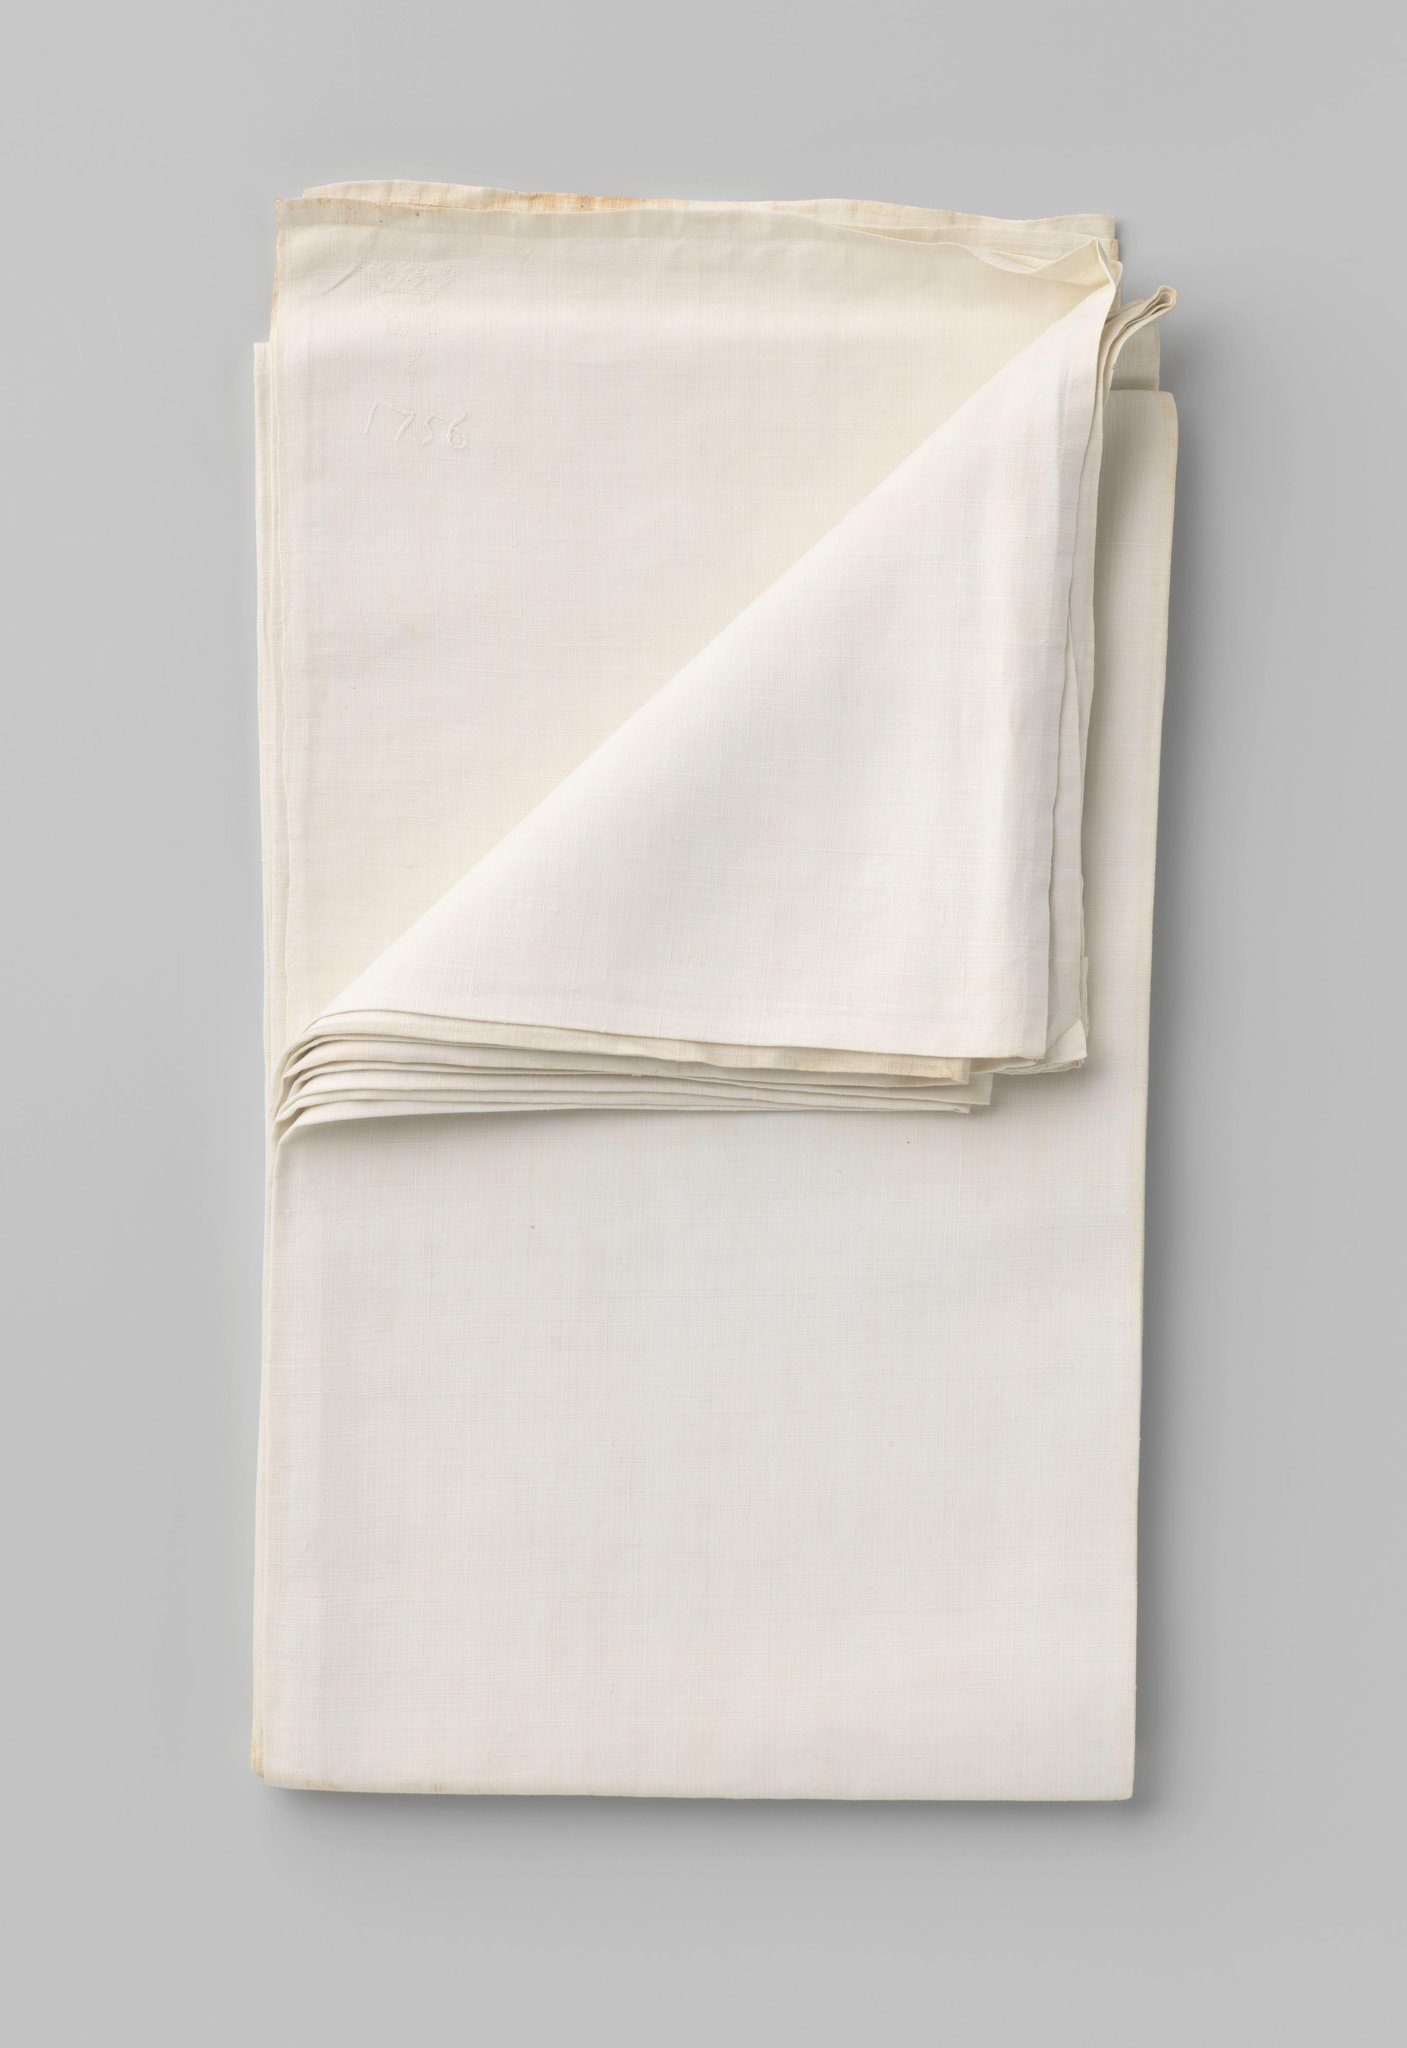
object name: beddenlaken, laken object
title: Laken. Merk: WG6 en jaartal 1756.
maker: Anonymous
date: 1756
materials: linen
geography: northern netherlands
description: Laken van wit linnen, merk kroon WG 6 en jaartal 1756